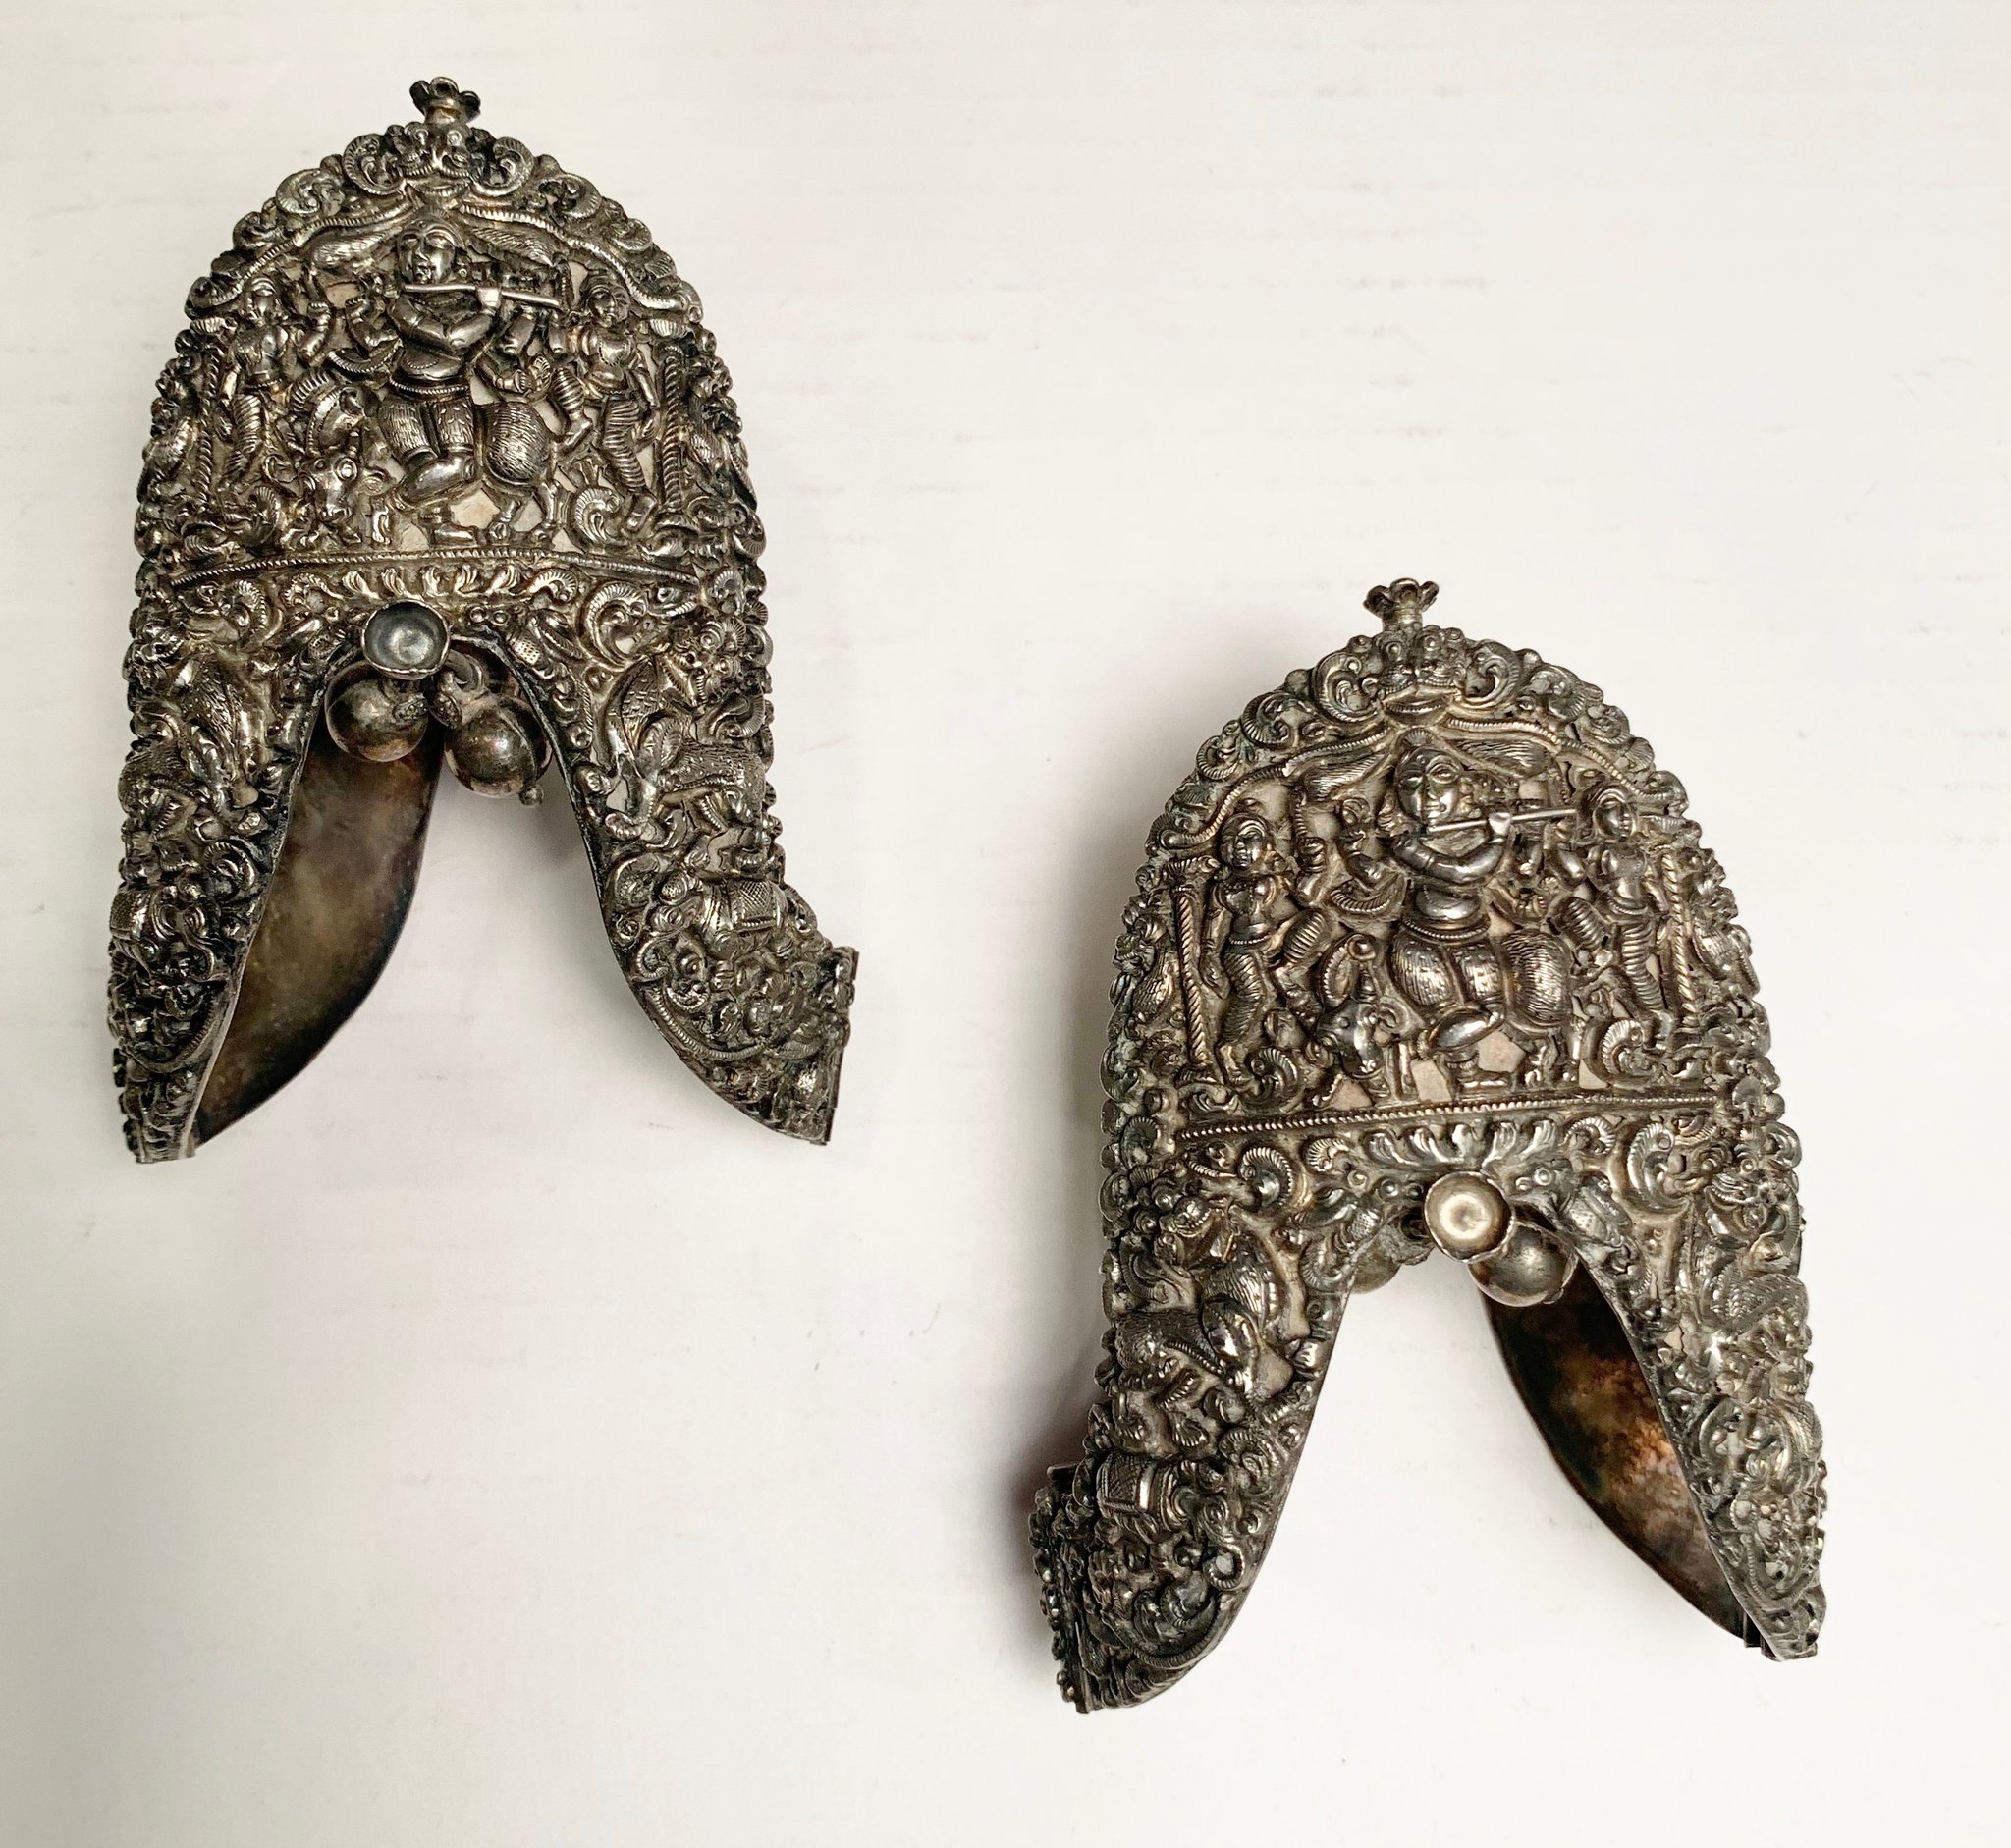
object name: armlet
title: Armlet, One of a Pair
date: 1801-1900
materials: silver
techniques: casting, chasing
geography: india